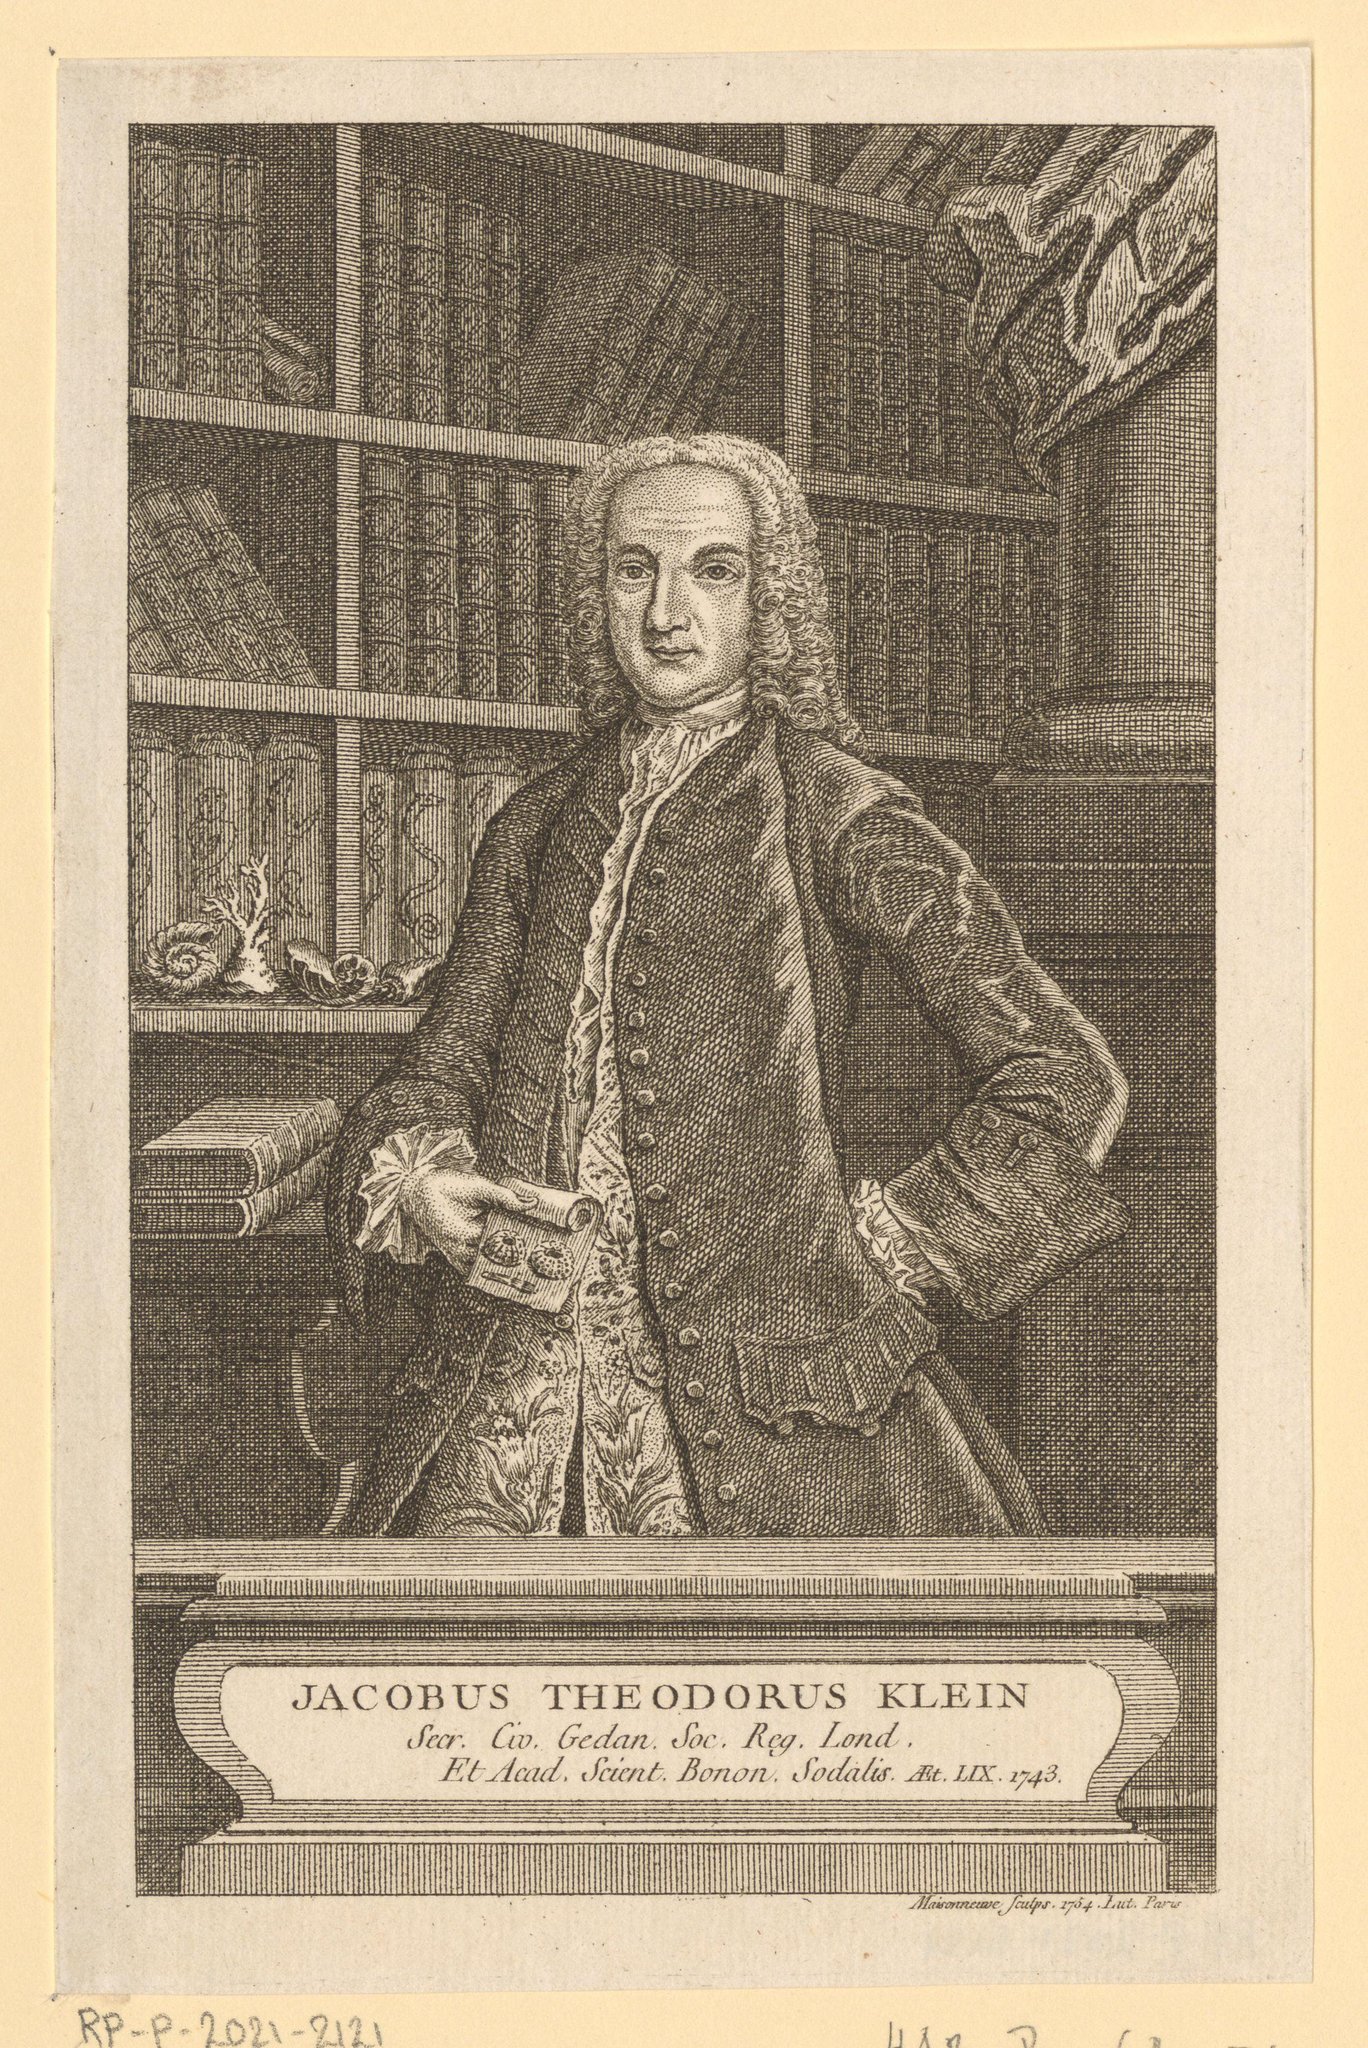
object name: print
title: Portret van Jacob Theodor Klein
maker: louis maisonneuve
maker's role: print maker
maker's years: 1719-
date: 1754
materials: paper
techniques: etching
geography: paris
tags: bookshelves, historical persons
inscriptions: date